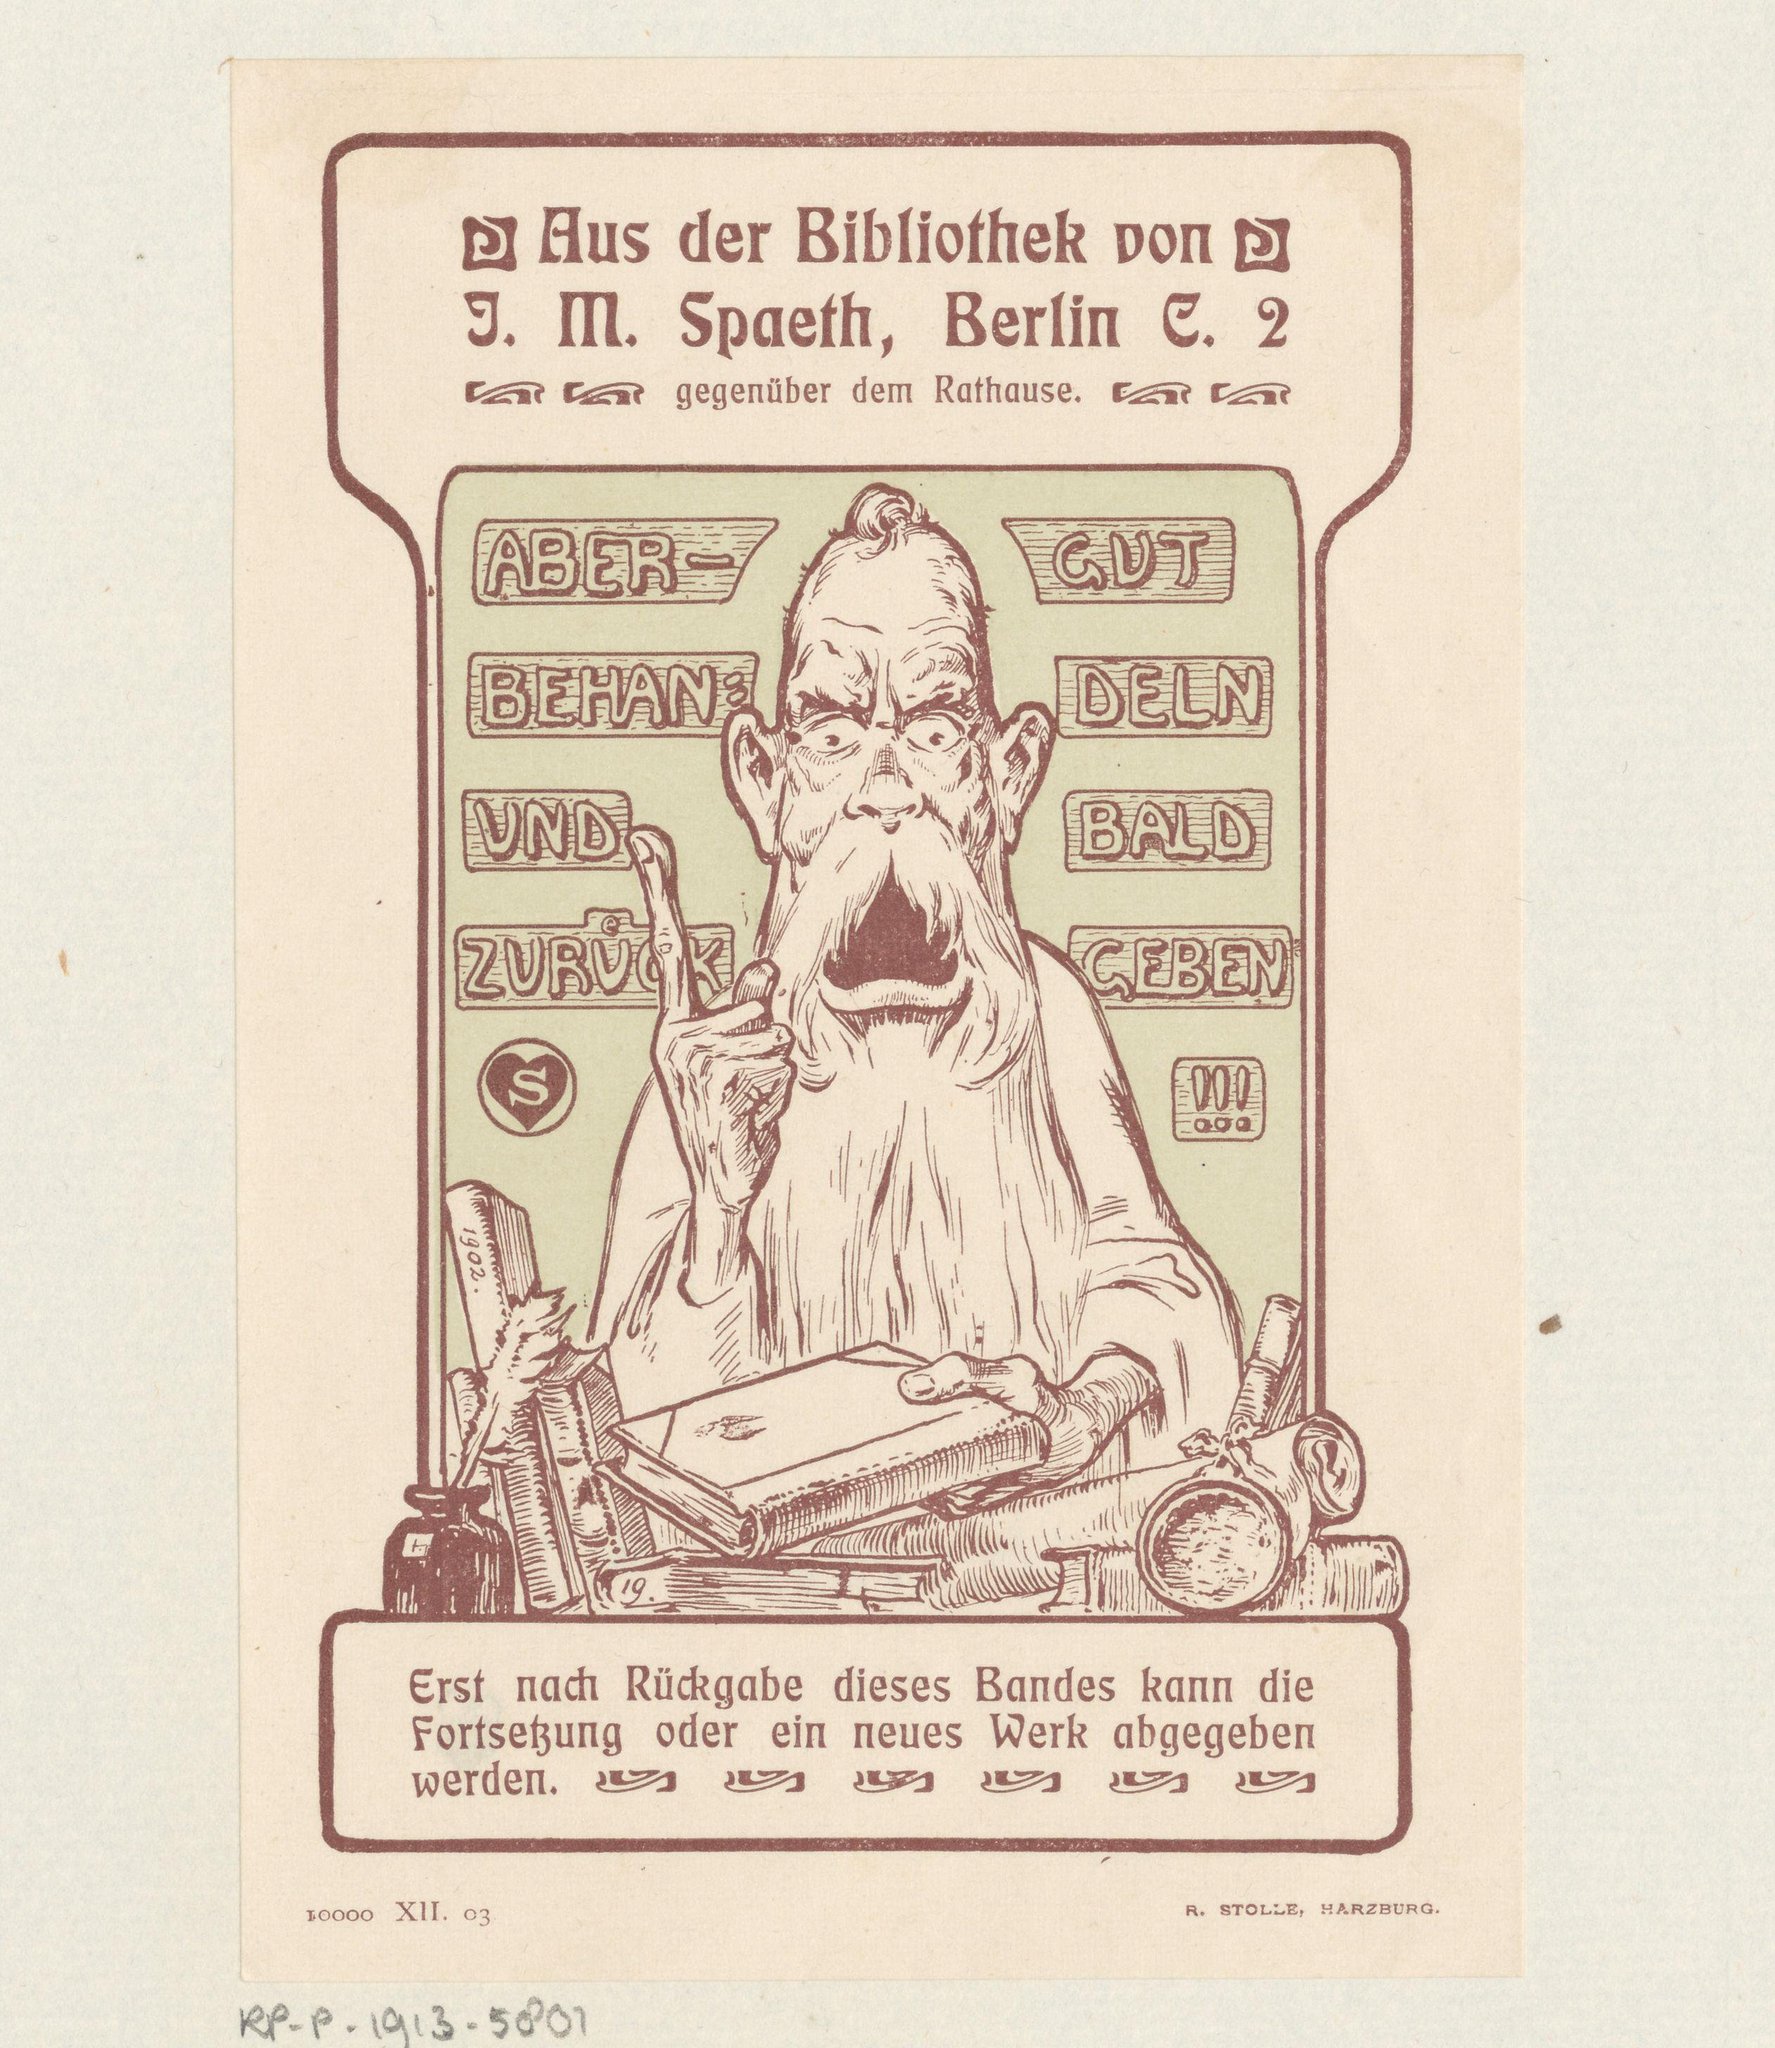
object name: bookplate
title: Ex libris van J.M. Spaeth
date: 1902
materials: paper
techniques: lithograph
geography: germany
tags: publisher, quill, old man, book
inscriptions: collector's mark: Lugt 2233, collector's mark: Lugt 2760